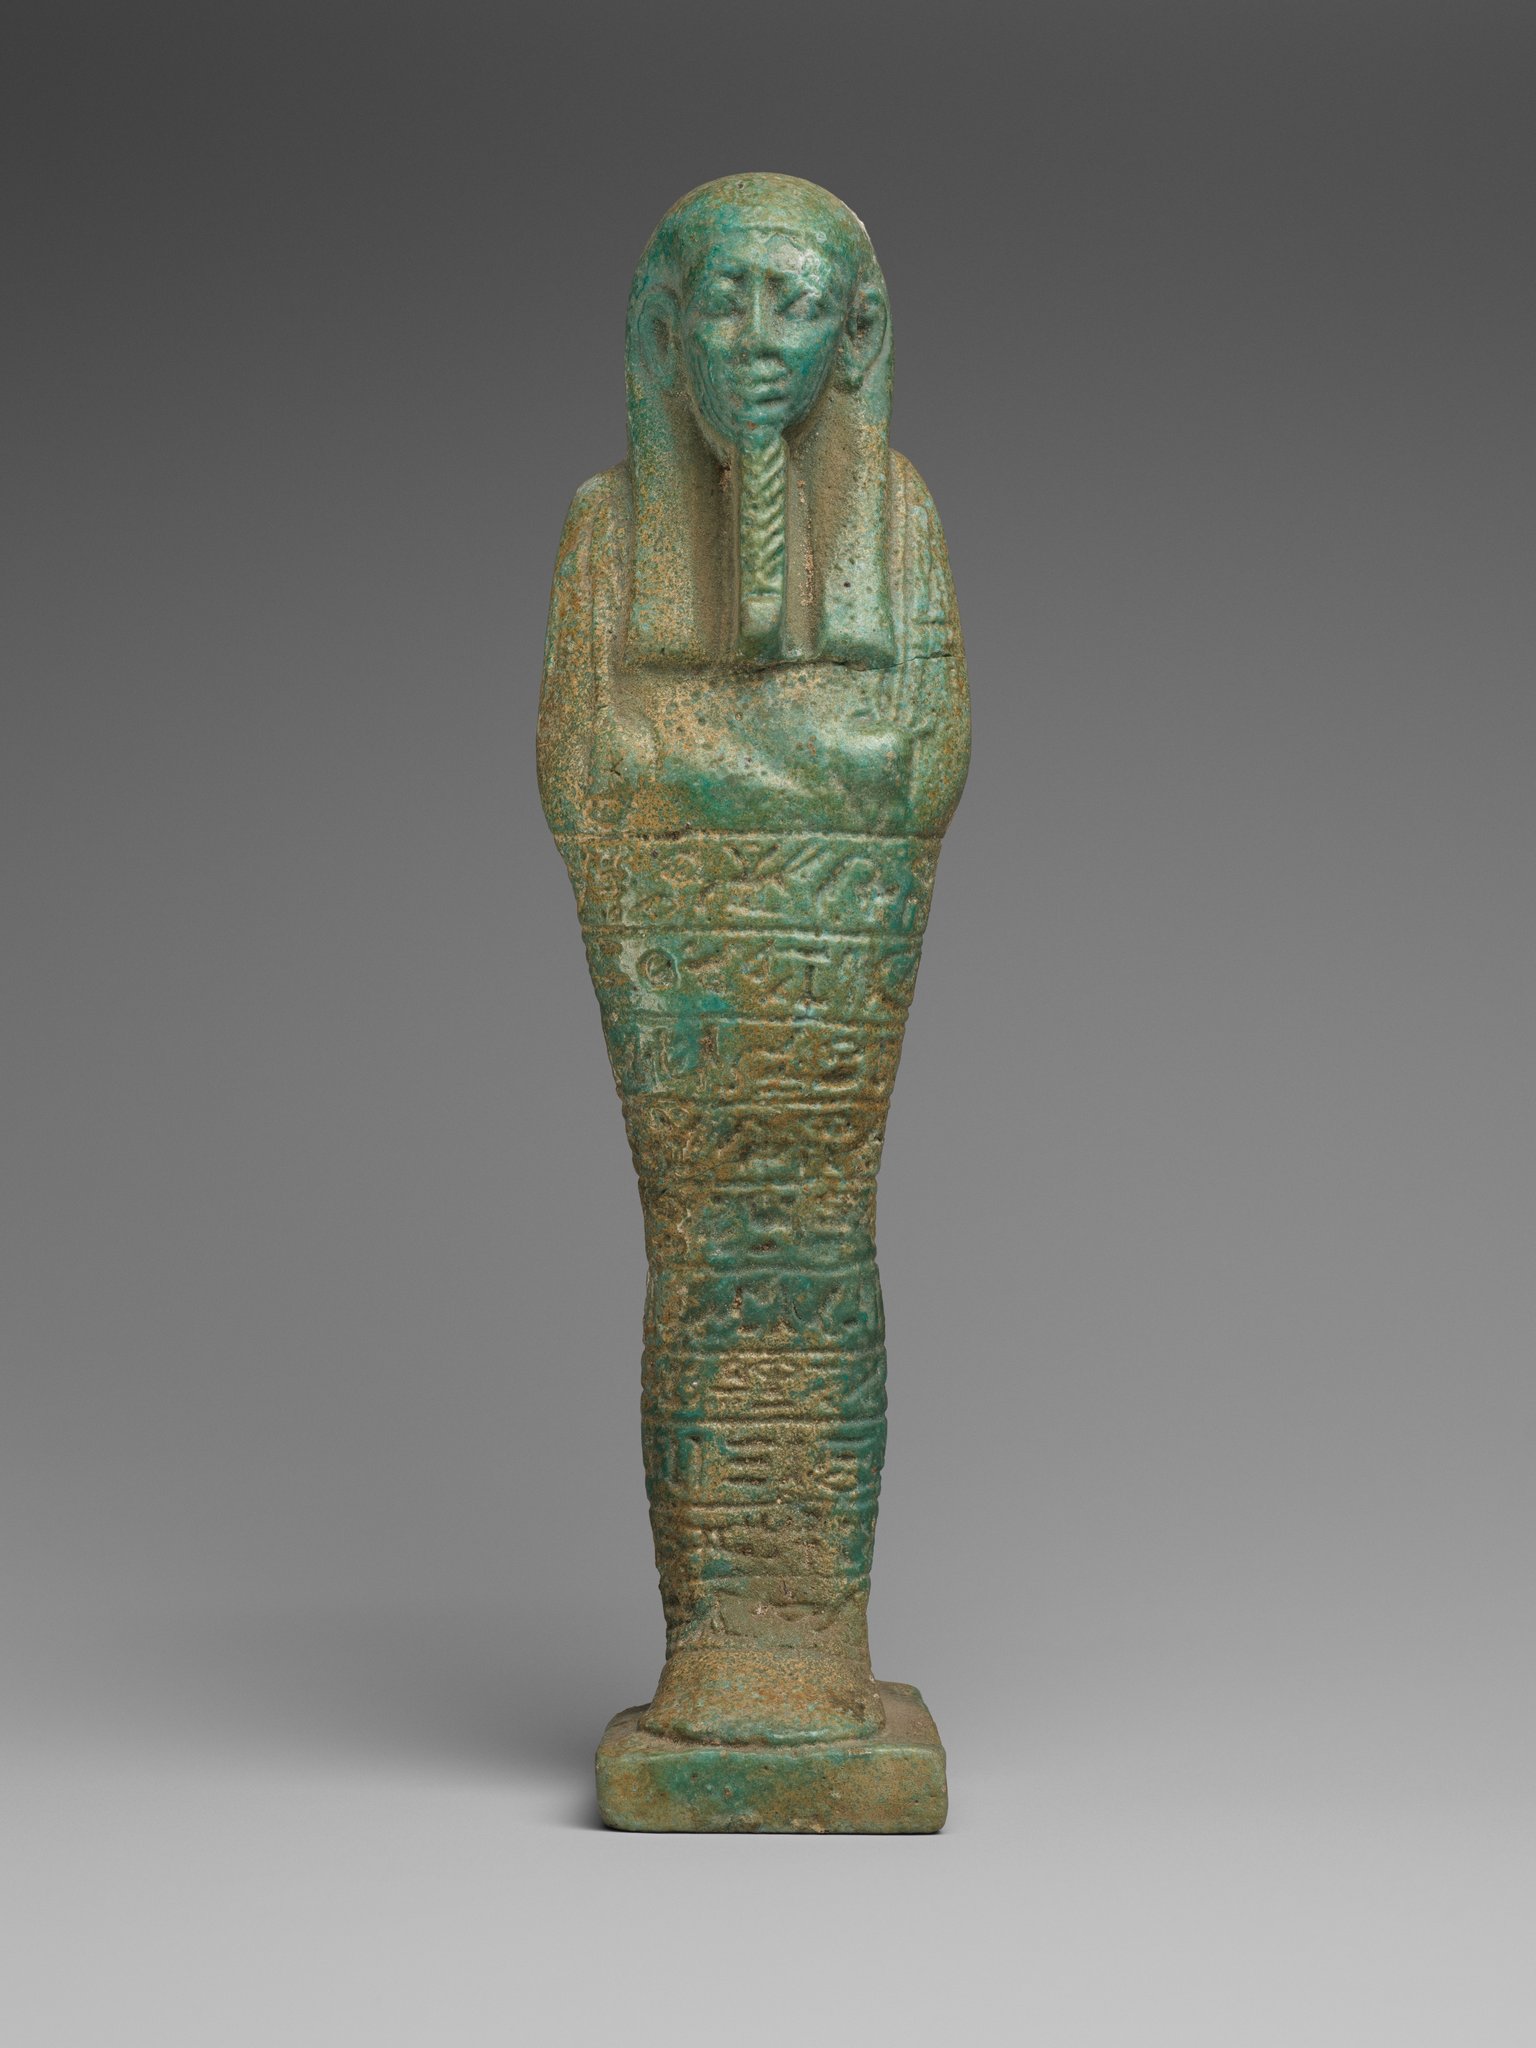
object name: shabti, pa abu meh, psamtik seneb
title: Shabti of the Treasurer of Lower Egypt Pa-abumeh, called Psamtik-seneb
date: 595-380 BCE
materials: faience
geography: egypt